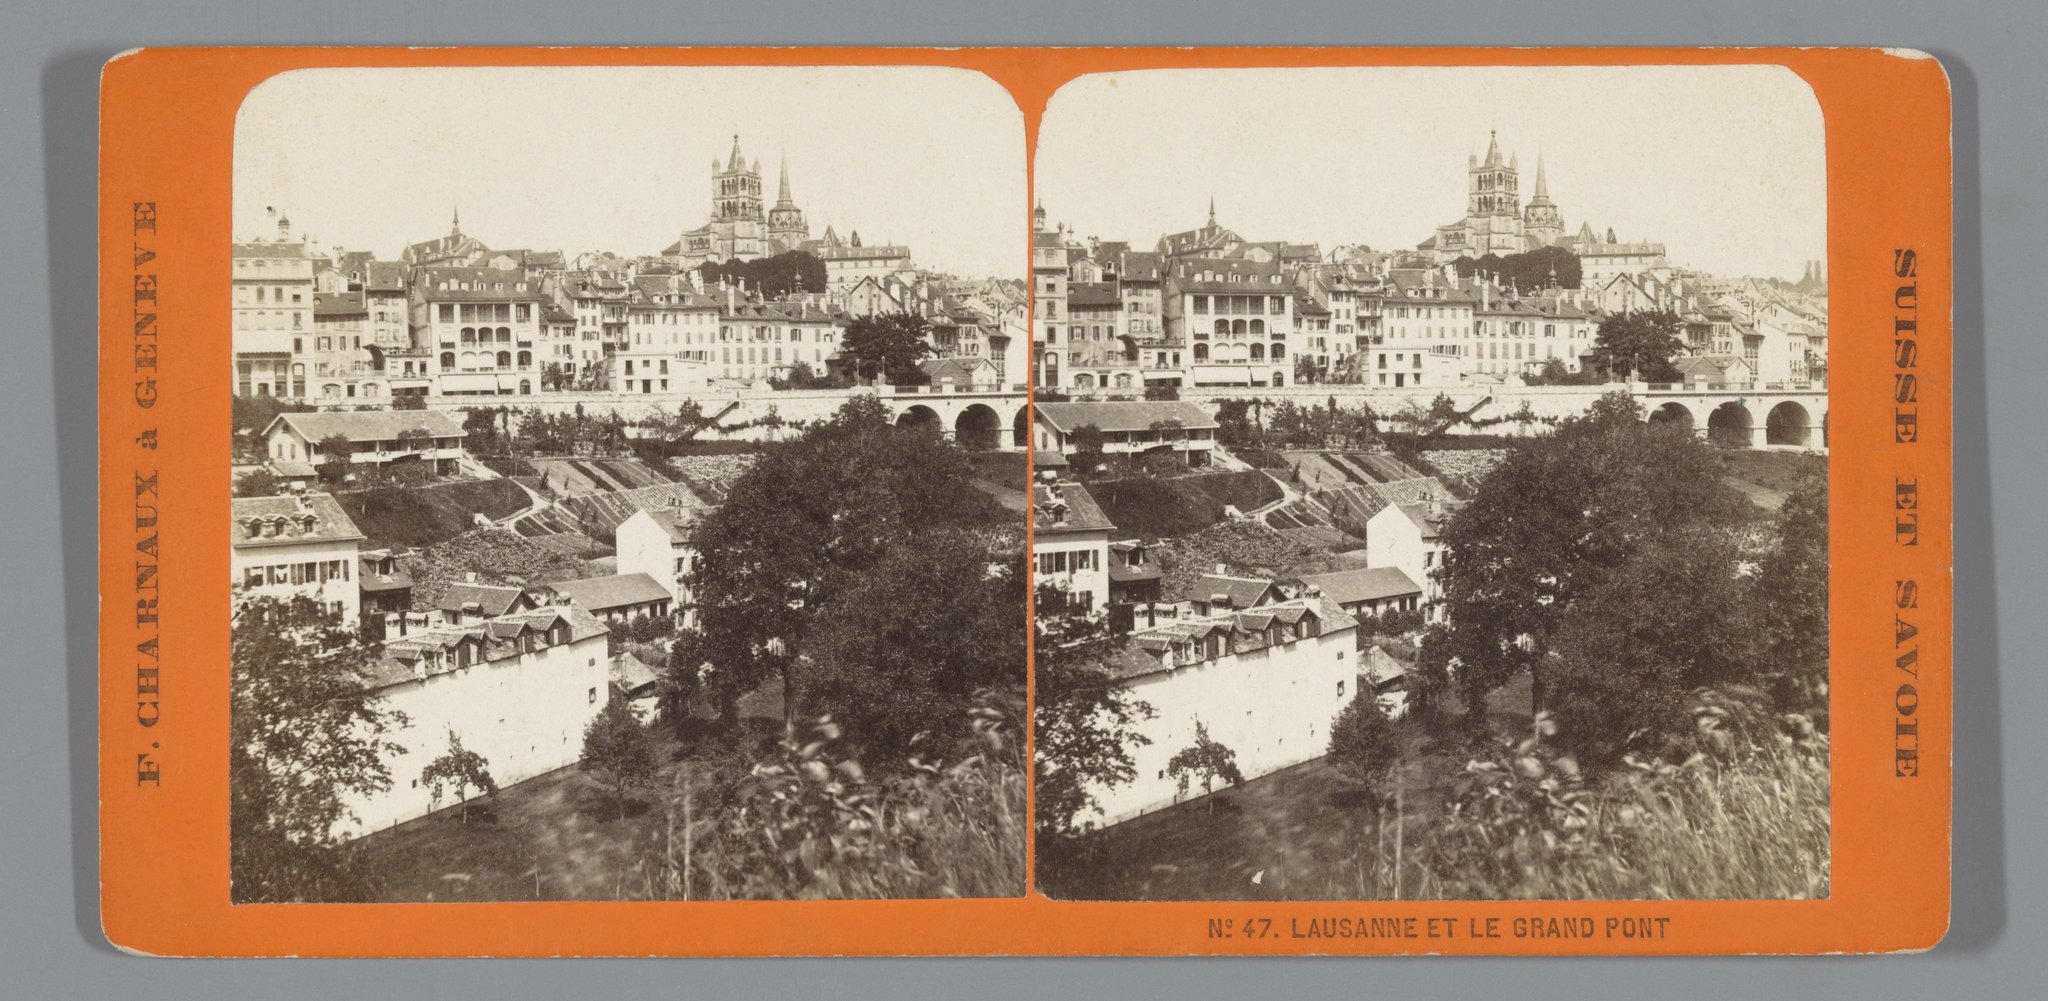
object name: stereograph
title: Gezicht op Lausanne, in de verte de Kathedraal van Lausanne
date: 1870-1890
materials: cardboard, paper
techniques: albumen print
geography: geneva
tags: city-view in general; 'veduta'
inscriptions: inscription: ‘Lausanne’